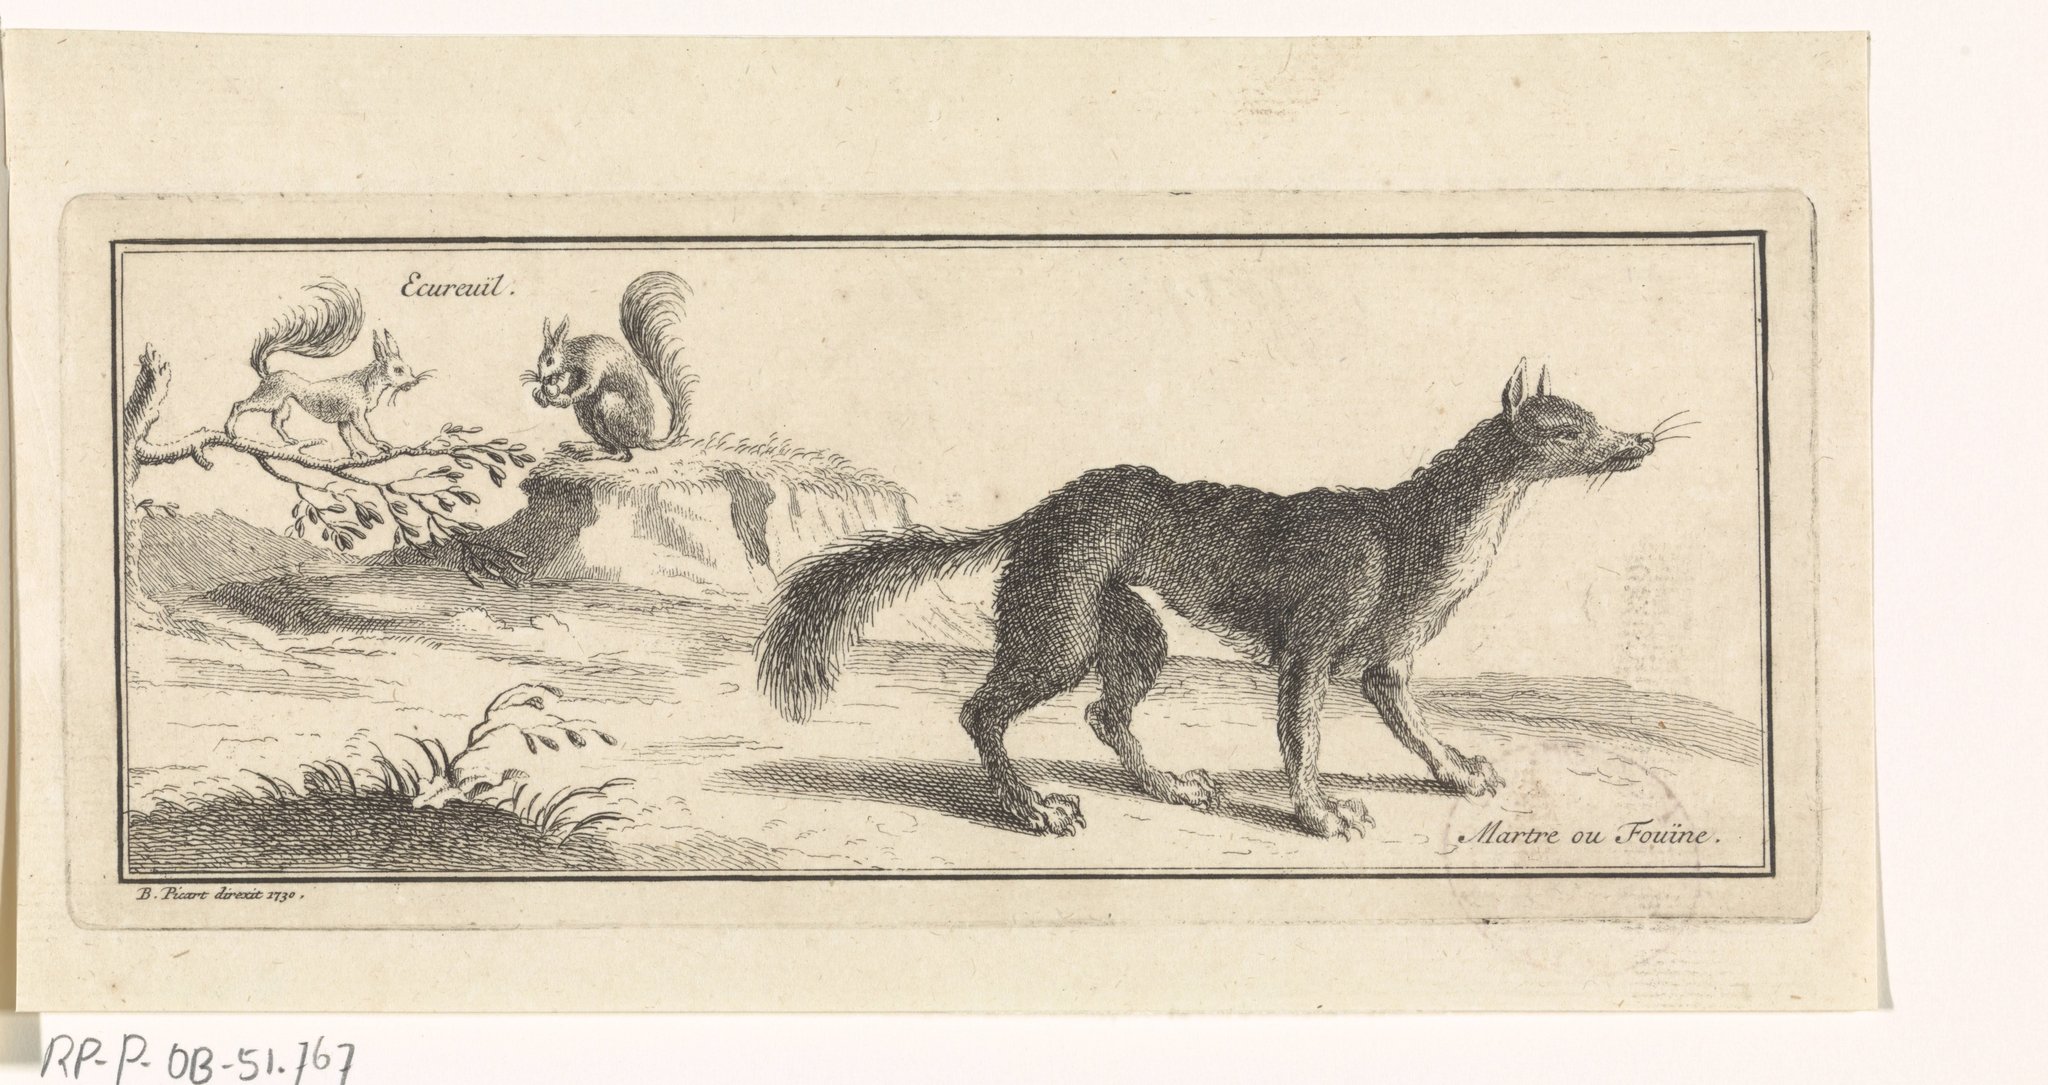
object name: book illustration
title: Eekhoorns en een marter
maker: bernard picart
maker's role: draughtsman, print maker, publisher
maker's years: 1673-1733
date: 1730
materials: paper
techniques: engraving, etching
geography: amsterdam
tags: rodents: squirrel, beasts of prey, predatory animals: marten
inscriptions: collector's mark: Lugt 240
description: Prent bedoeld voor: Chomel, Noel. Dictionnaire oeconomique, contenant divers moïens d'augmenter son bien, et de conserver sa santé. Amsterdam: Johannes Covens en Cornelis Mortier, 1732.